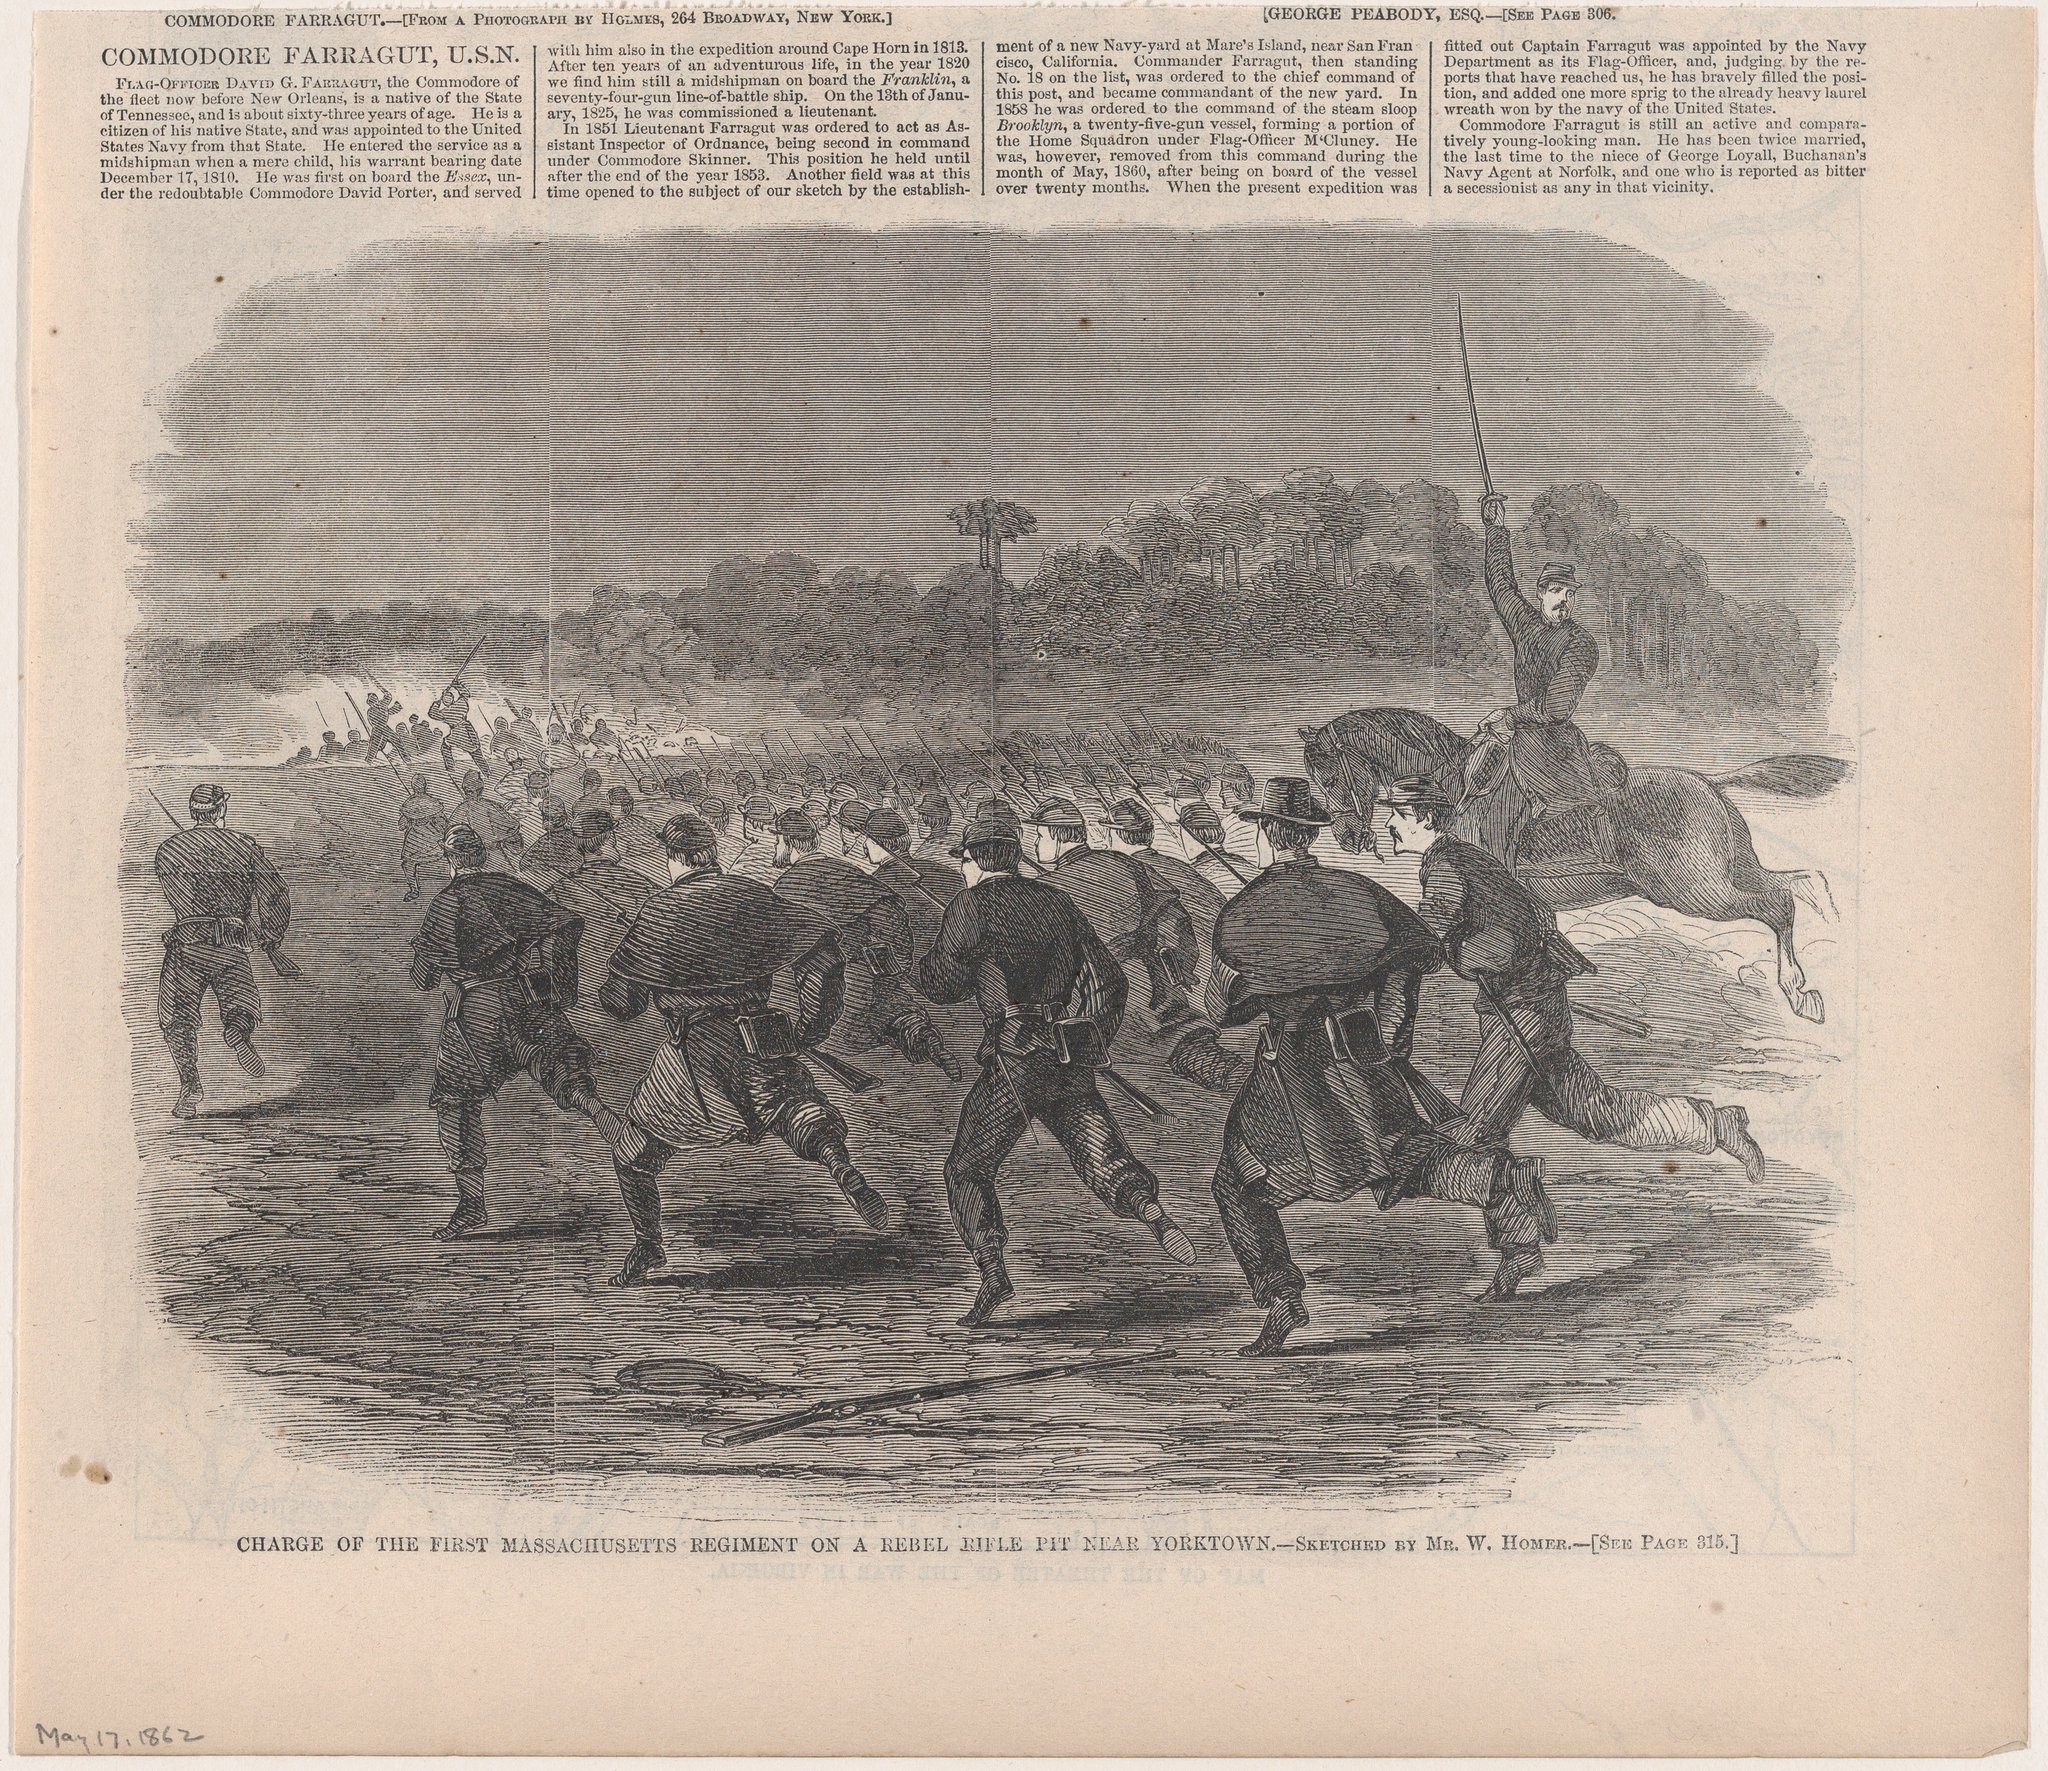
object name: print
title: Charge of the First Massachusetts Regiment on a Rebel Rifle Pit Near Yorktown (from "Harper's Weekly," Vol. VI)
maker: winslow homer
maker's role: artist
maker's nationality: american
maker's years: 1836-1910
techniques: engraving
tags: soldiers,american civil war,men,horses